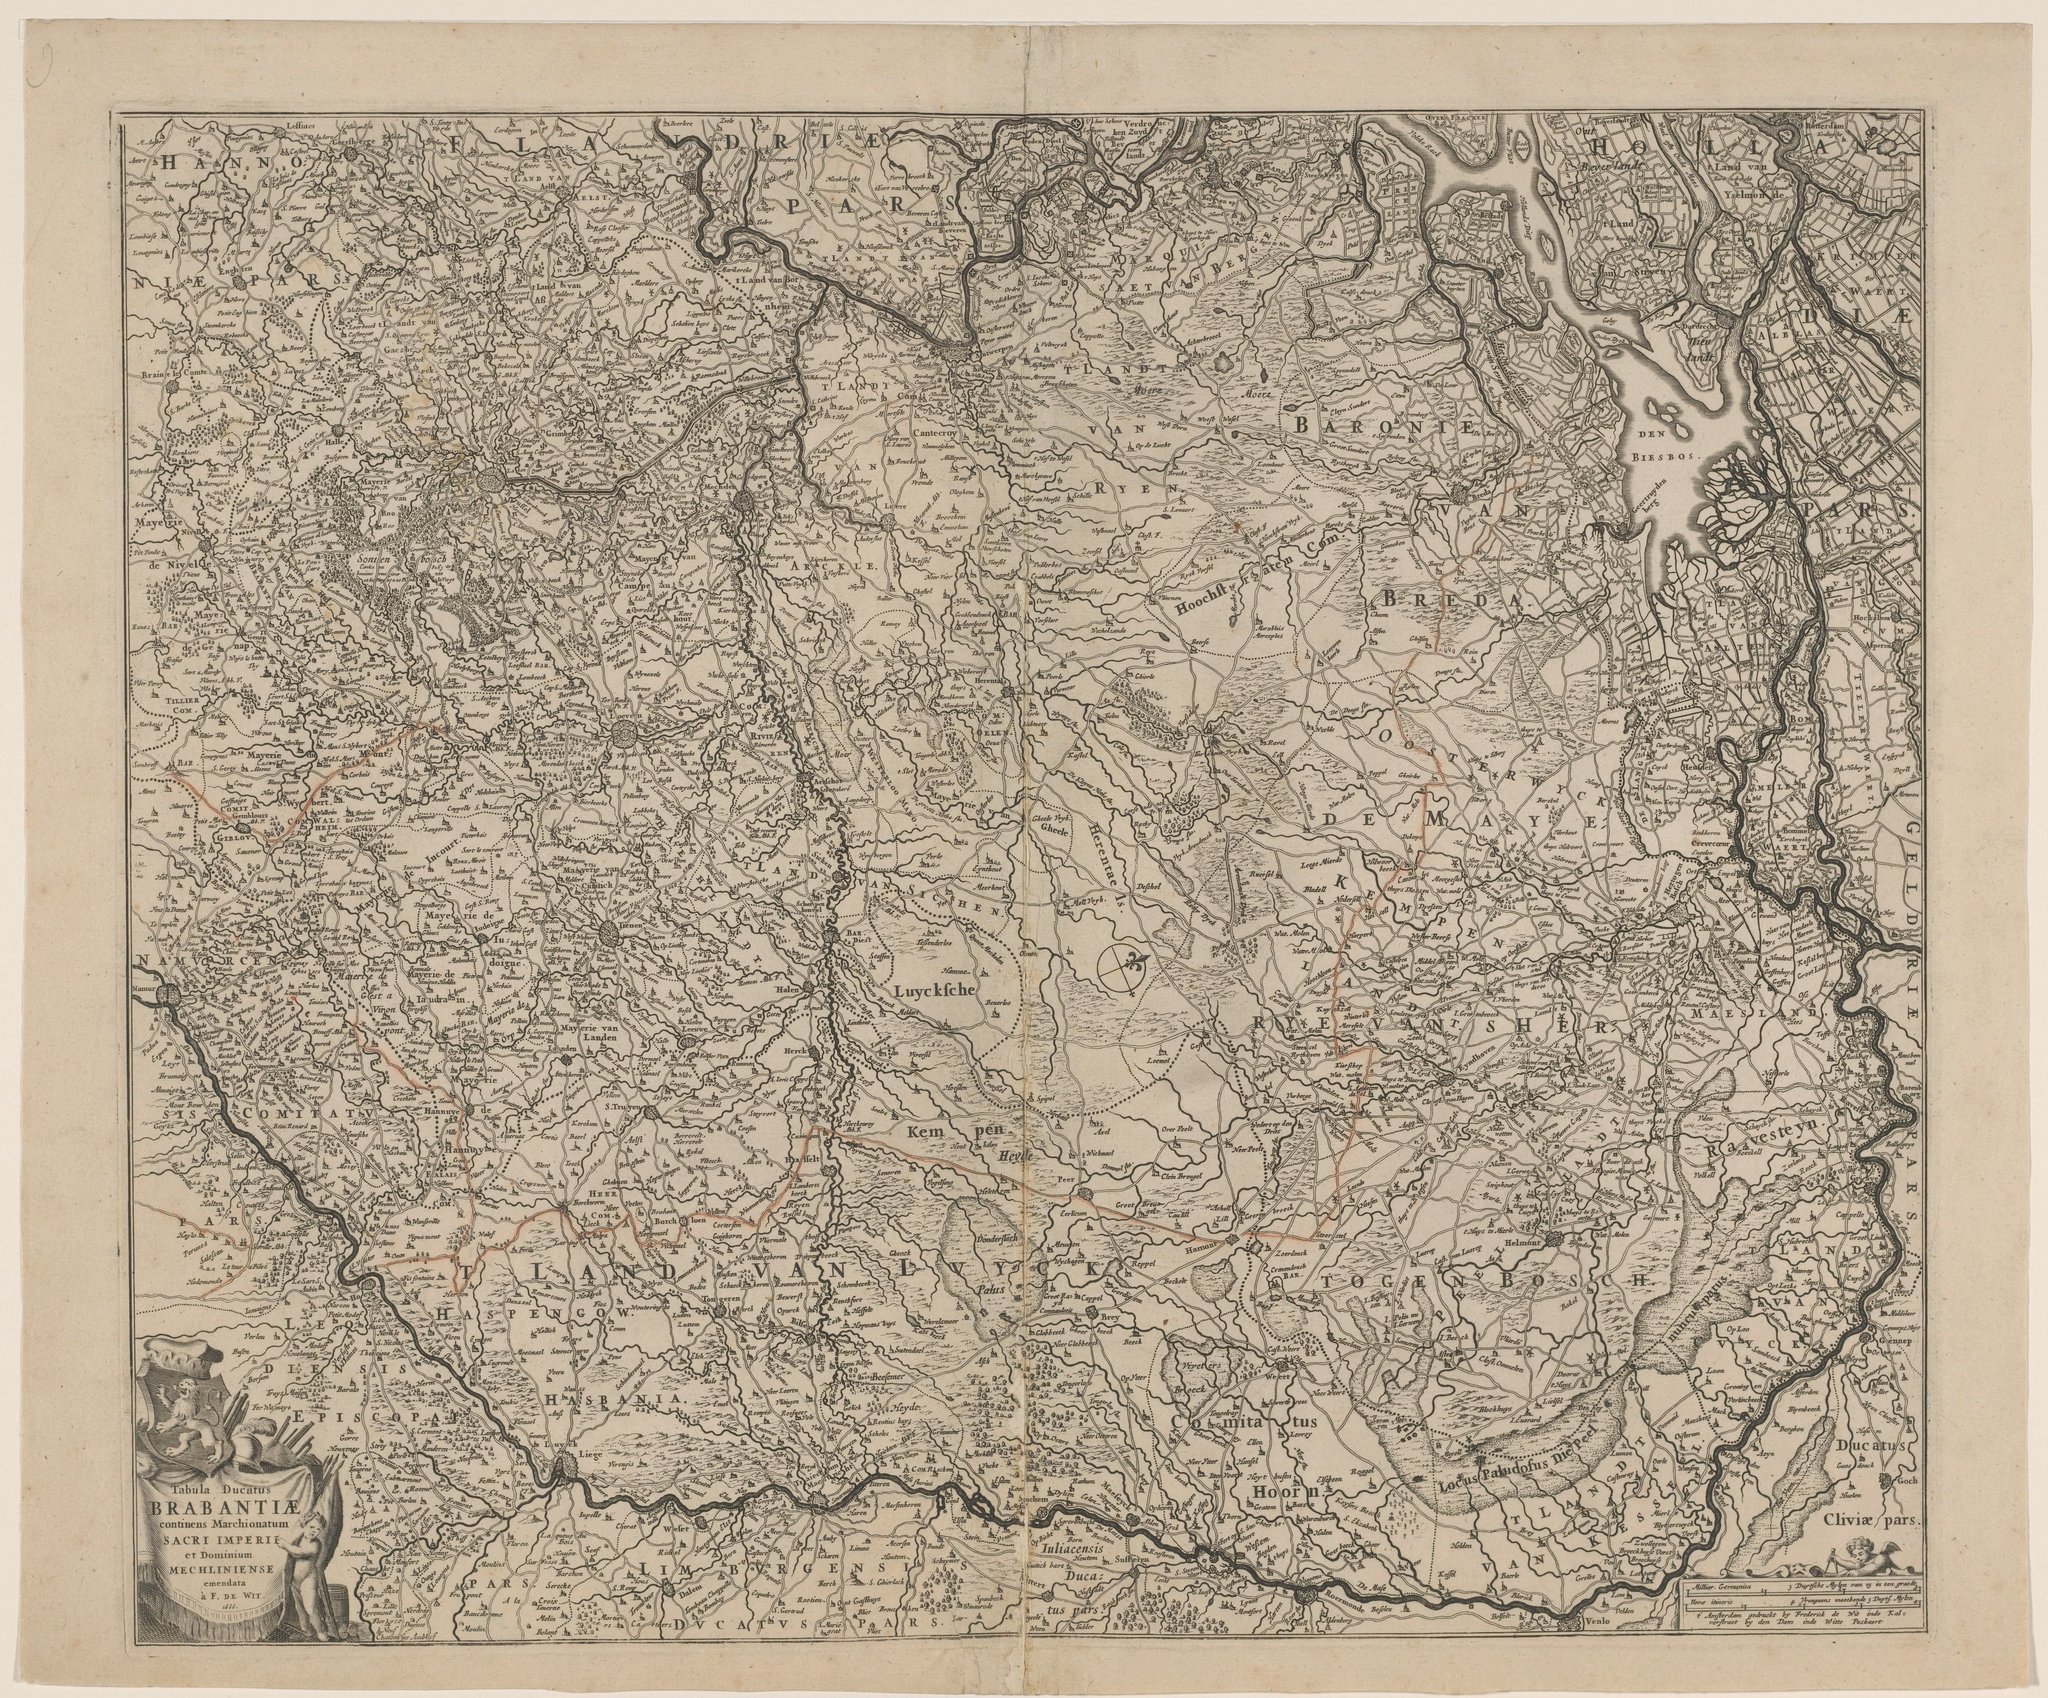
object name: map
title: Kaart van het hertogdom Brabant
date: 1666-1670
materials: paper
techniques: engraving, etching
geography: amsterdam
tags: maps of separate countries or regions, coat of arms (as symbol of the state, etc.) (+ province; provincial), brabant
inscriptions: collector's mark: Lugt 2228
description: Kaart van het hertogdom Brabant. Linksonder de titelcartouche met bovenin het wapen van het hertogdom Brabant. Rechtsonder een cartouche met twee schaalstokken: 3 Duytsche Mijlen van 15 in een graede / 4 Urengaens mackende 3 Duyts. Mylen.